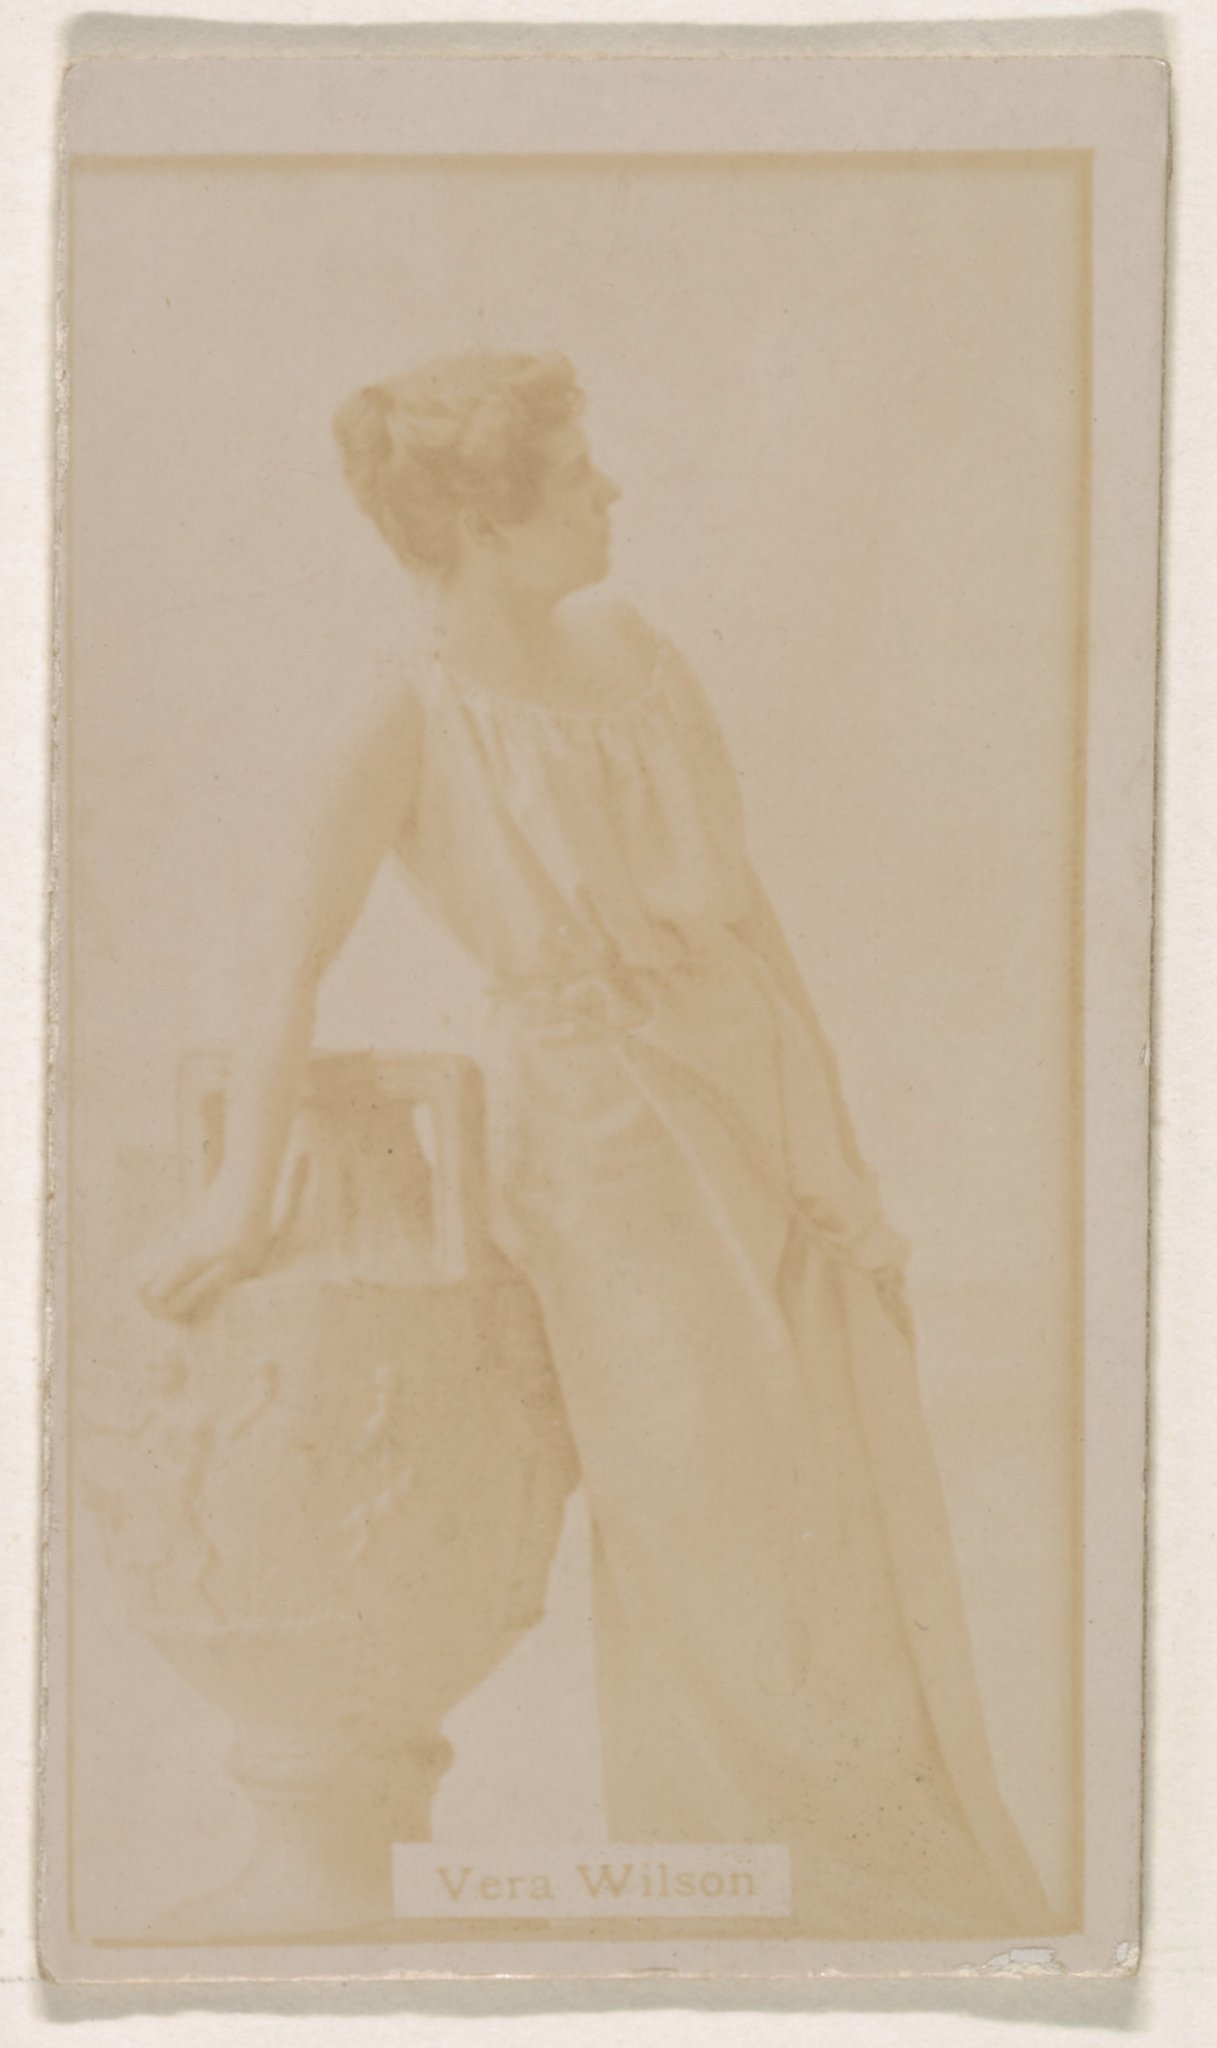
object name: photograph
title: Vera Wilson, from the Actresses series (N245) issued by Kinney Brothers to promote Sweet Caporal Cigarettes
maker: kinney brothers tobacco company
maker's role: publisher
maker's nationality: american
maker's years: 1869-2011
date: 1890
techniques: albumen silver print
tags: women,actresses